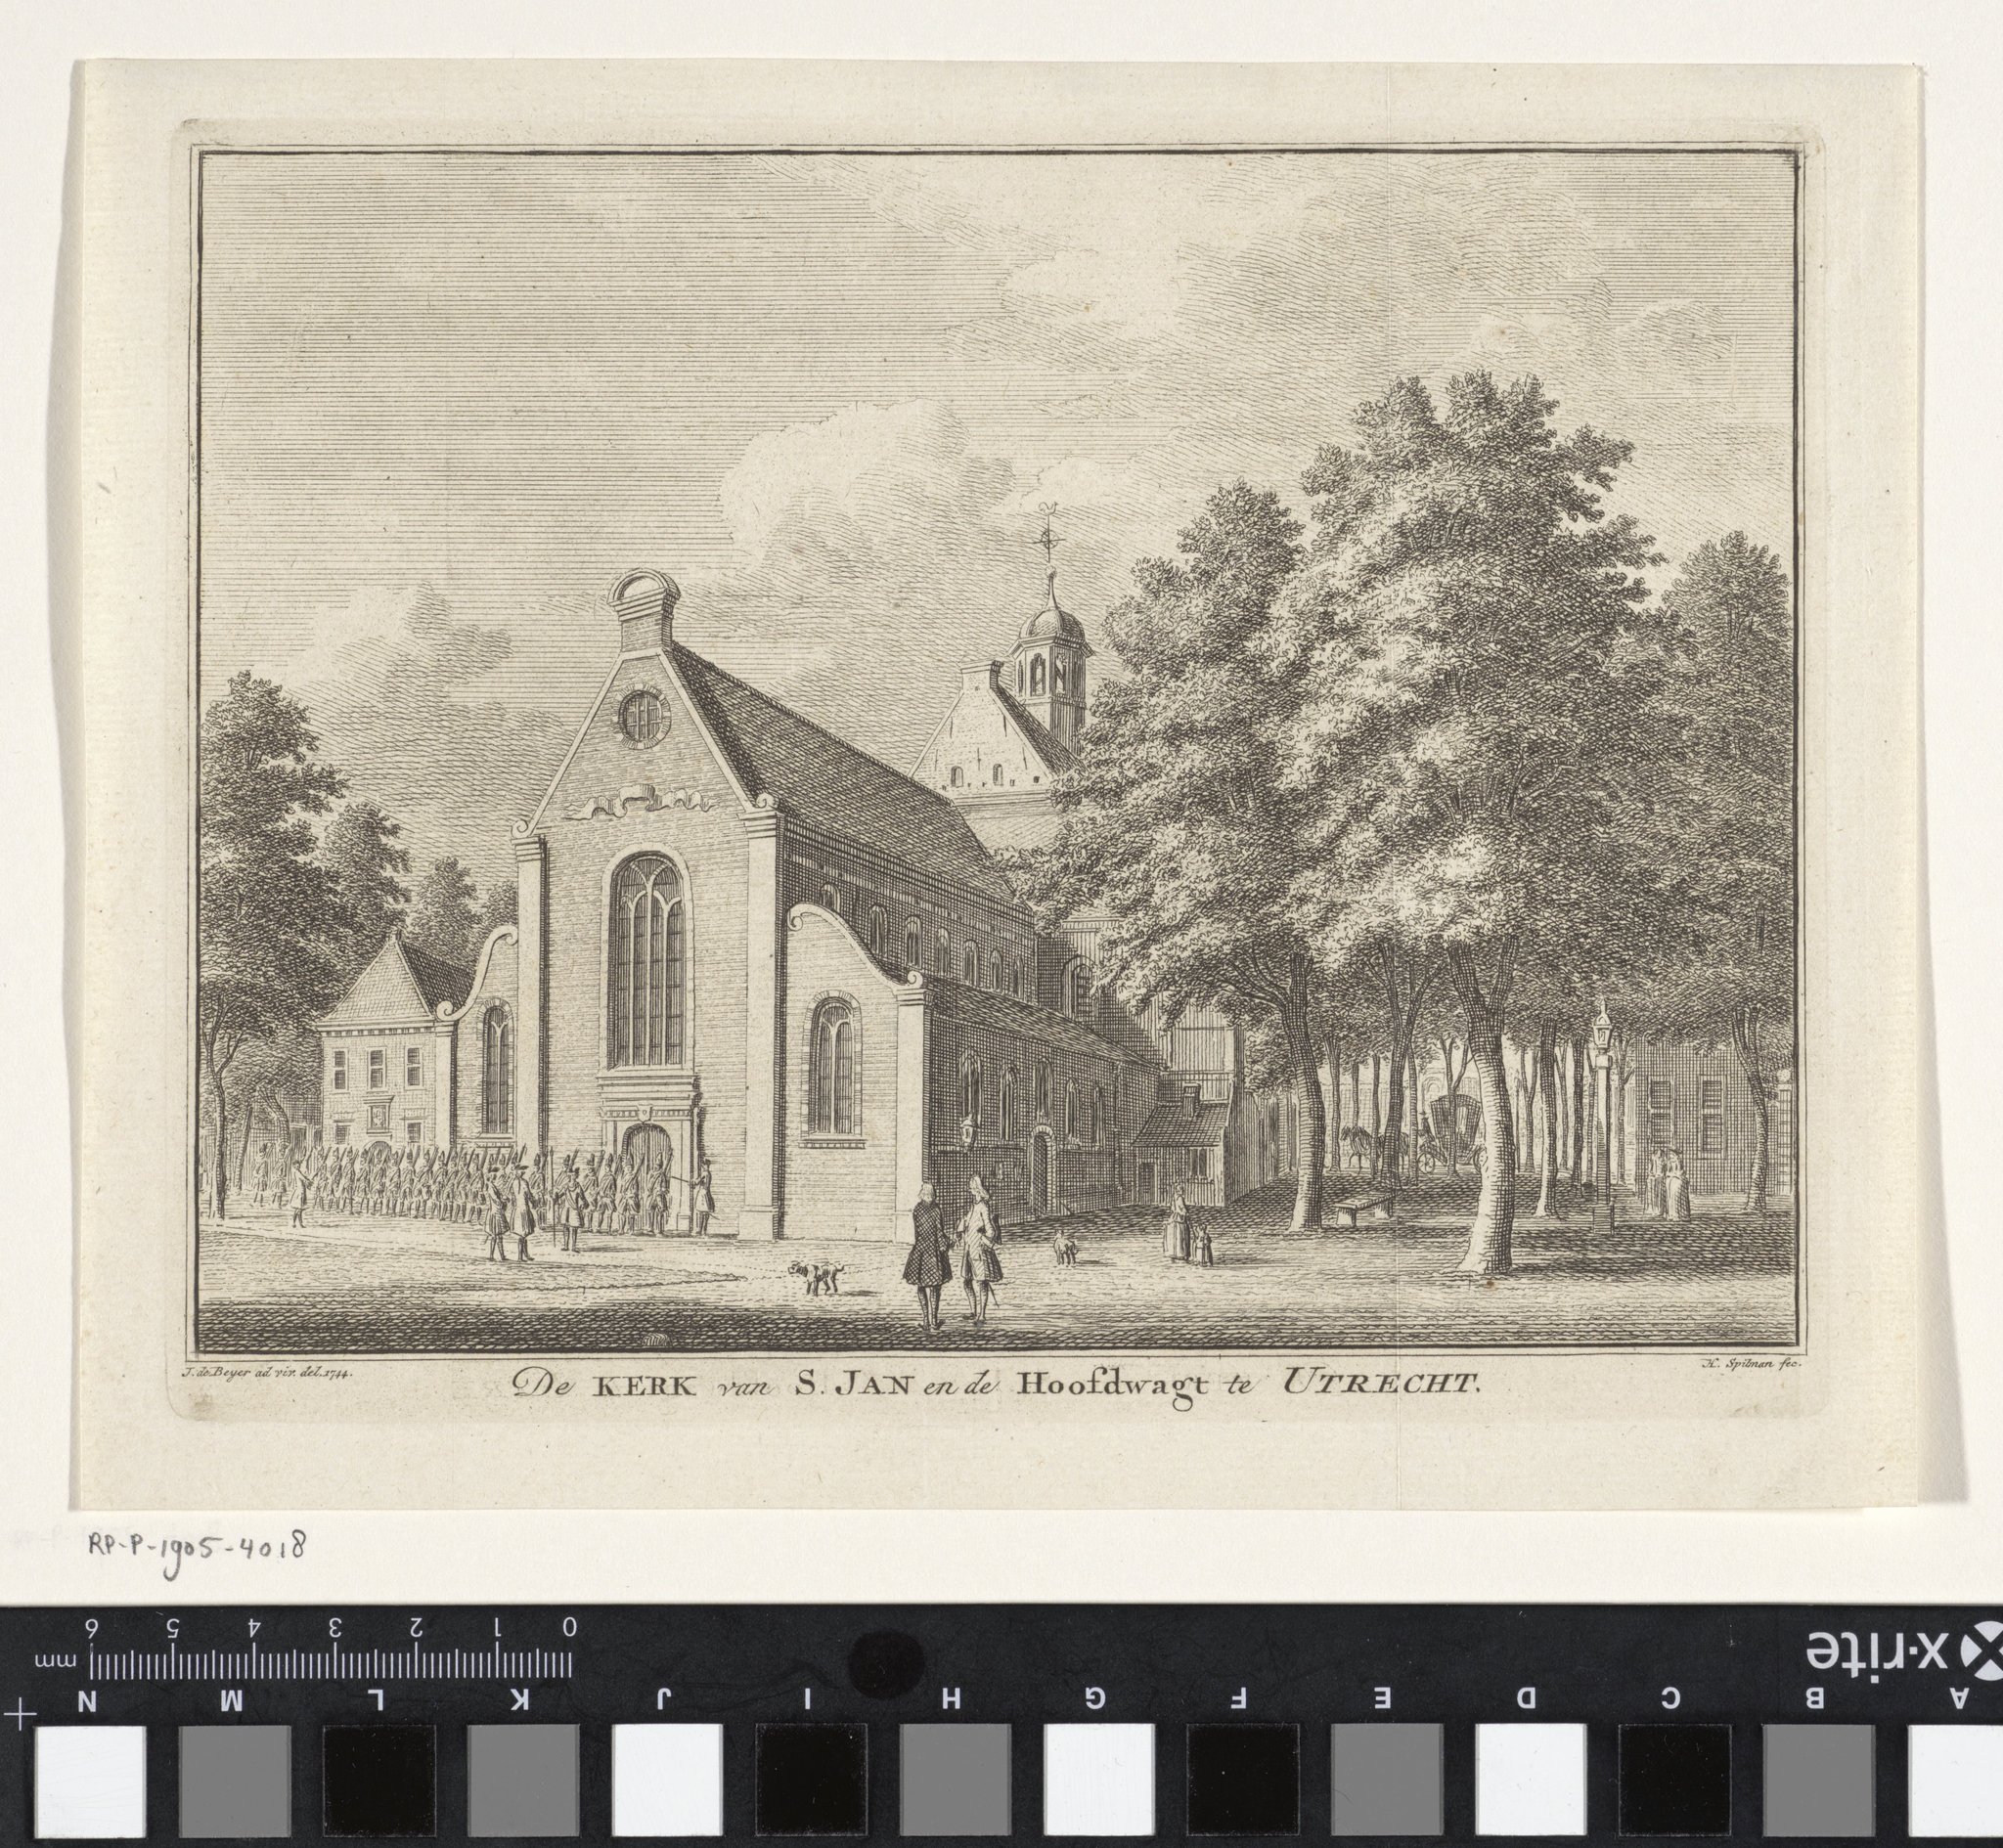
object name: print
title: Gezicht op de Janskerk en de wacht te Utrecht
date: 1744-1784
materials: paper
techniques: etching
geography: haarlem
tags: public road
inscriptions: collector's mark: Lugt 2228